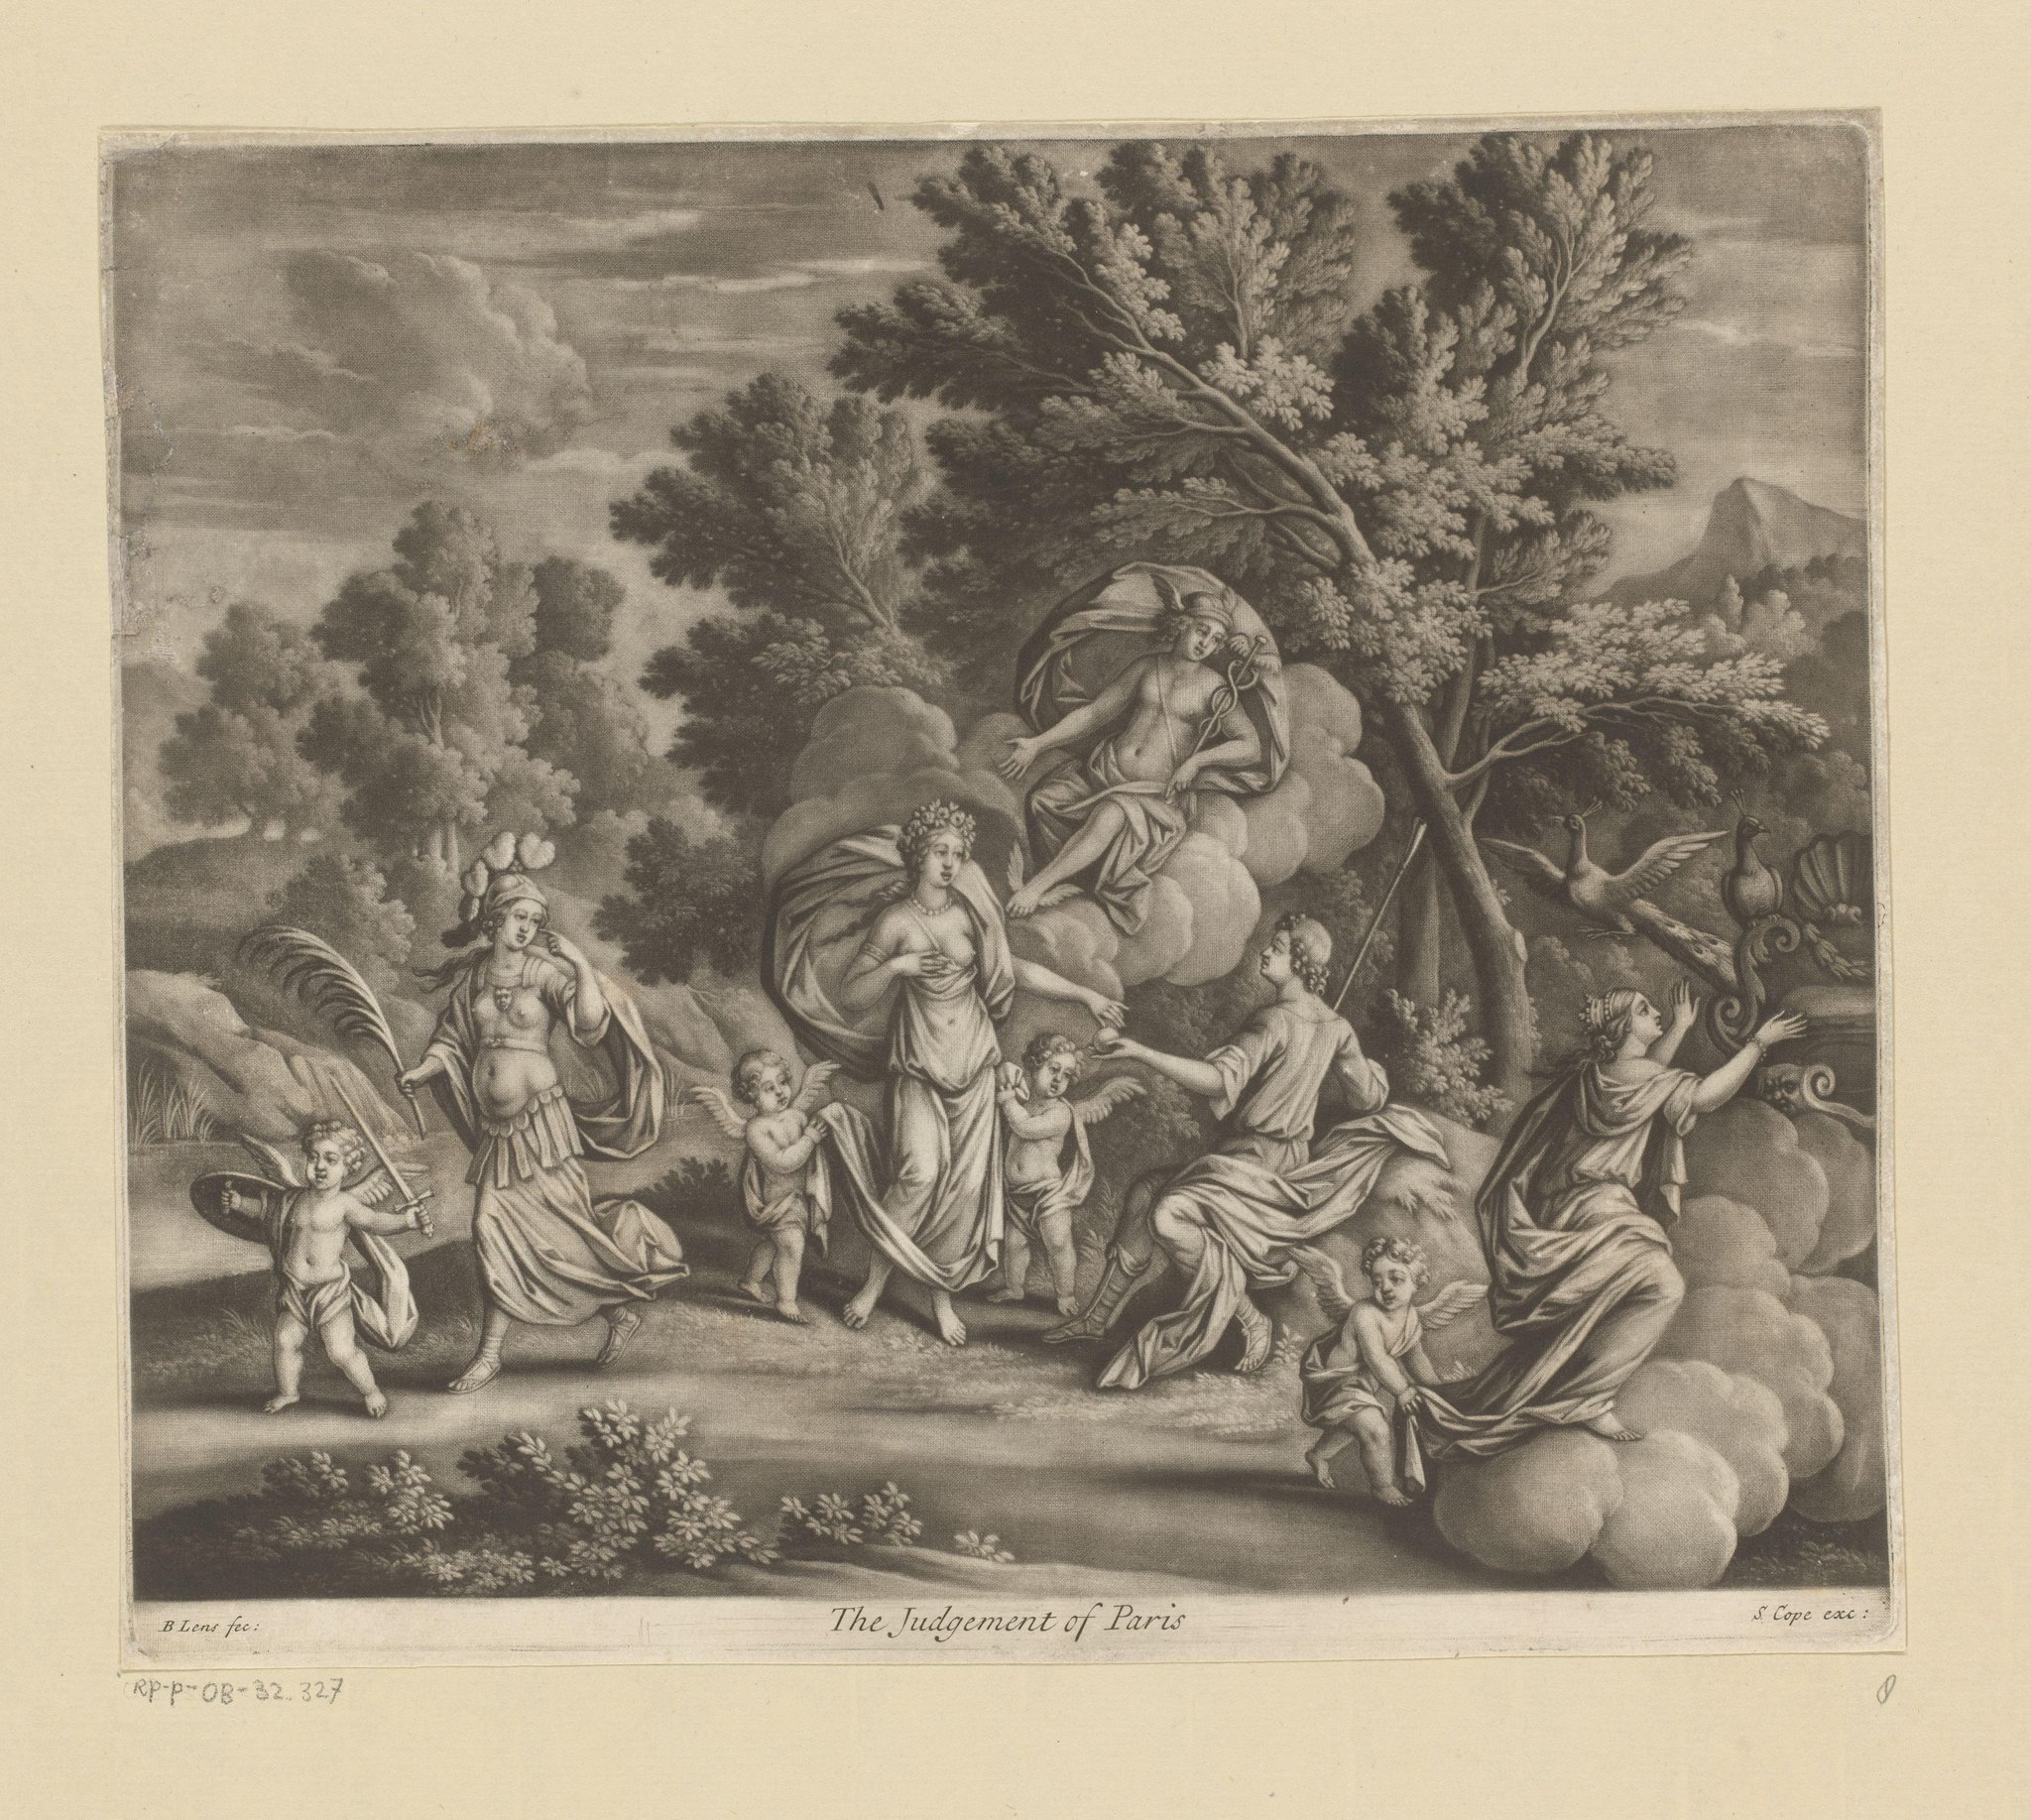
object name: print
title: The Judement of Paris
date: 1669-1725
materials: paper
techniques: etching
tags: the judgement of paris (without mercury)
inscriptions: collector's mark: Lugt 240